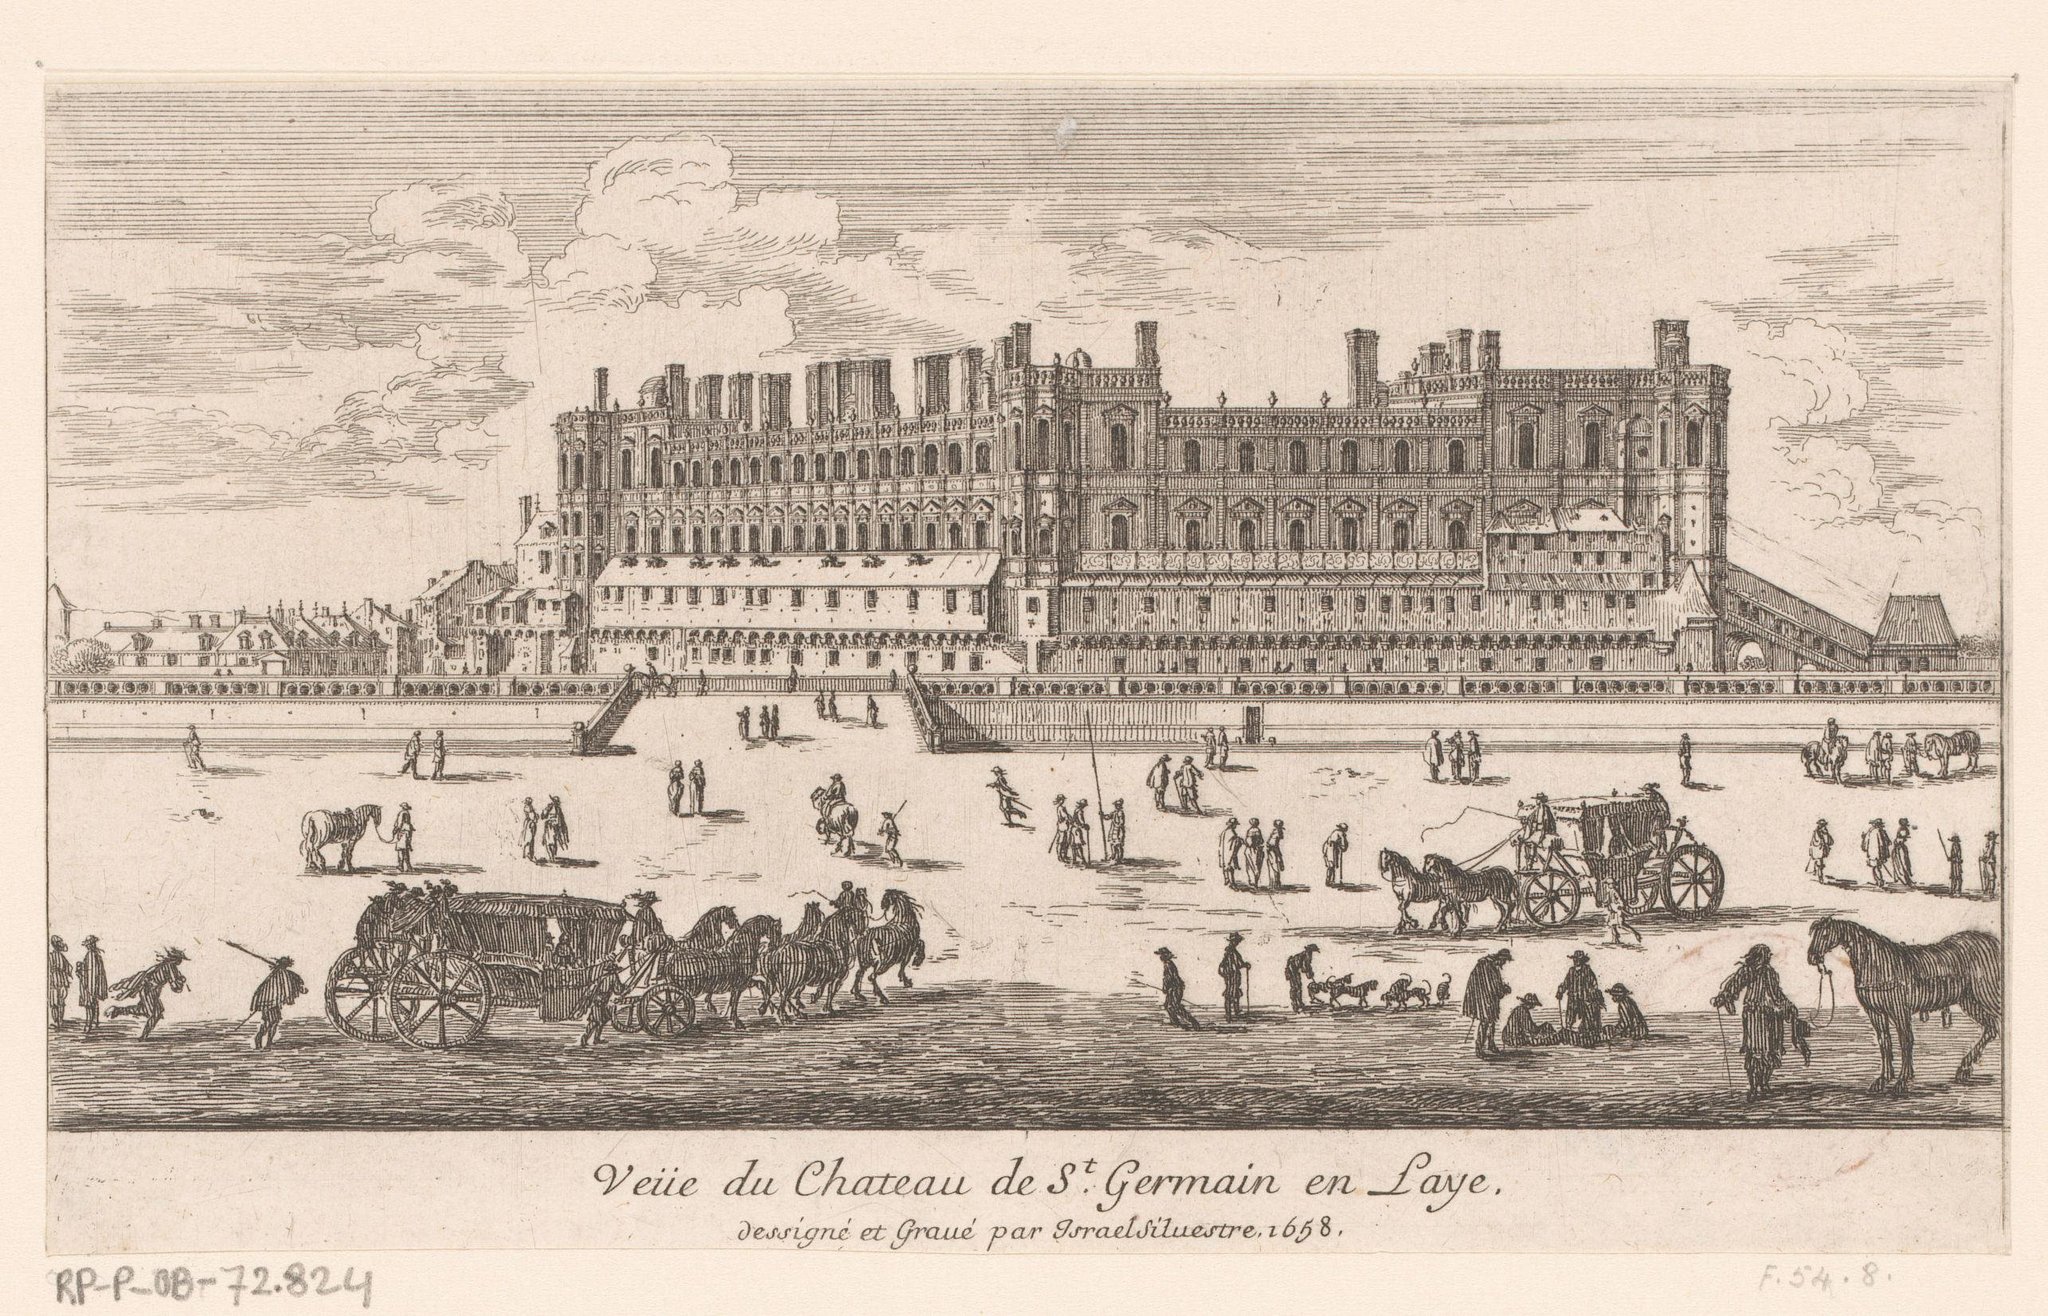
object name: print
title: Gezicht op het kasteel van Saint-Germain-en-Laye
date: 1658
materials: paper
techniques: etching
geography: france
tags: landscape with tower or castle (+ city(-scape) with figures, staffage)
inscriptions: collector's mark: Lugt 240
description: Prent maakt deel uit van een ongenummerde serie van tien prenten.